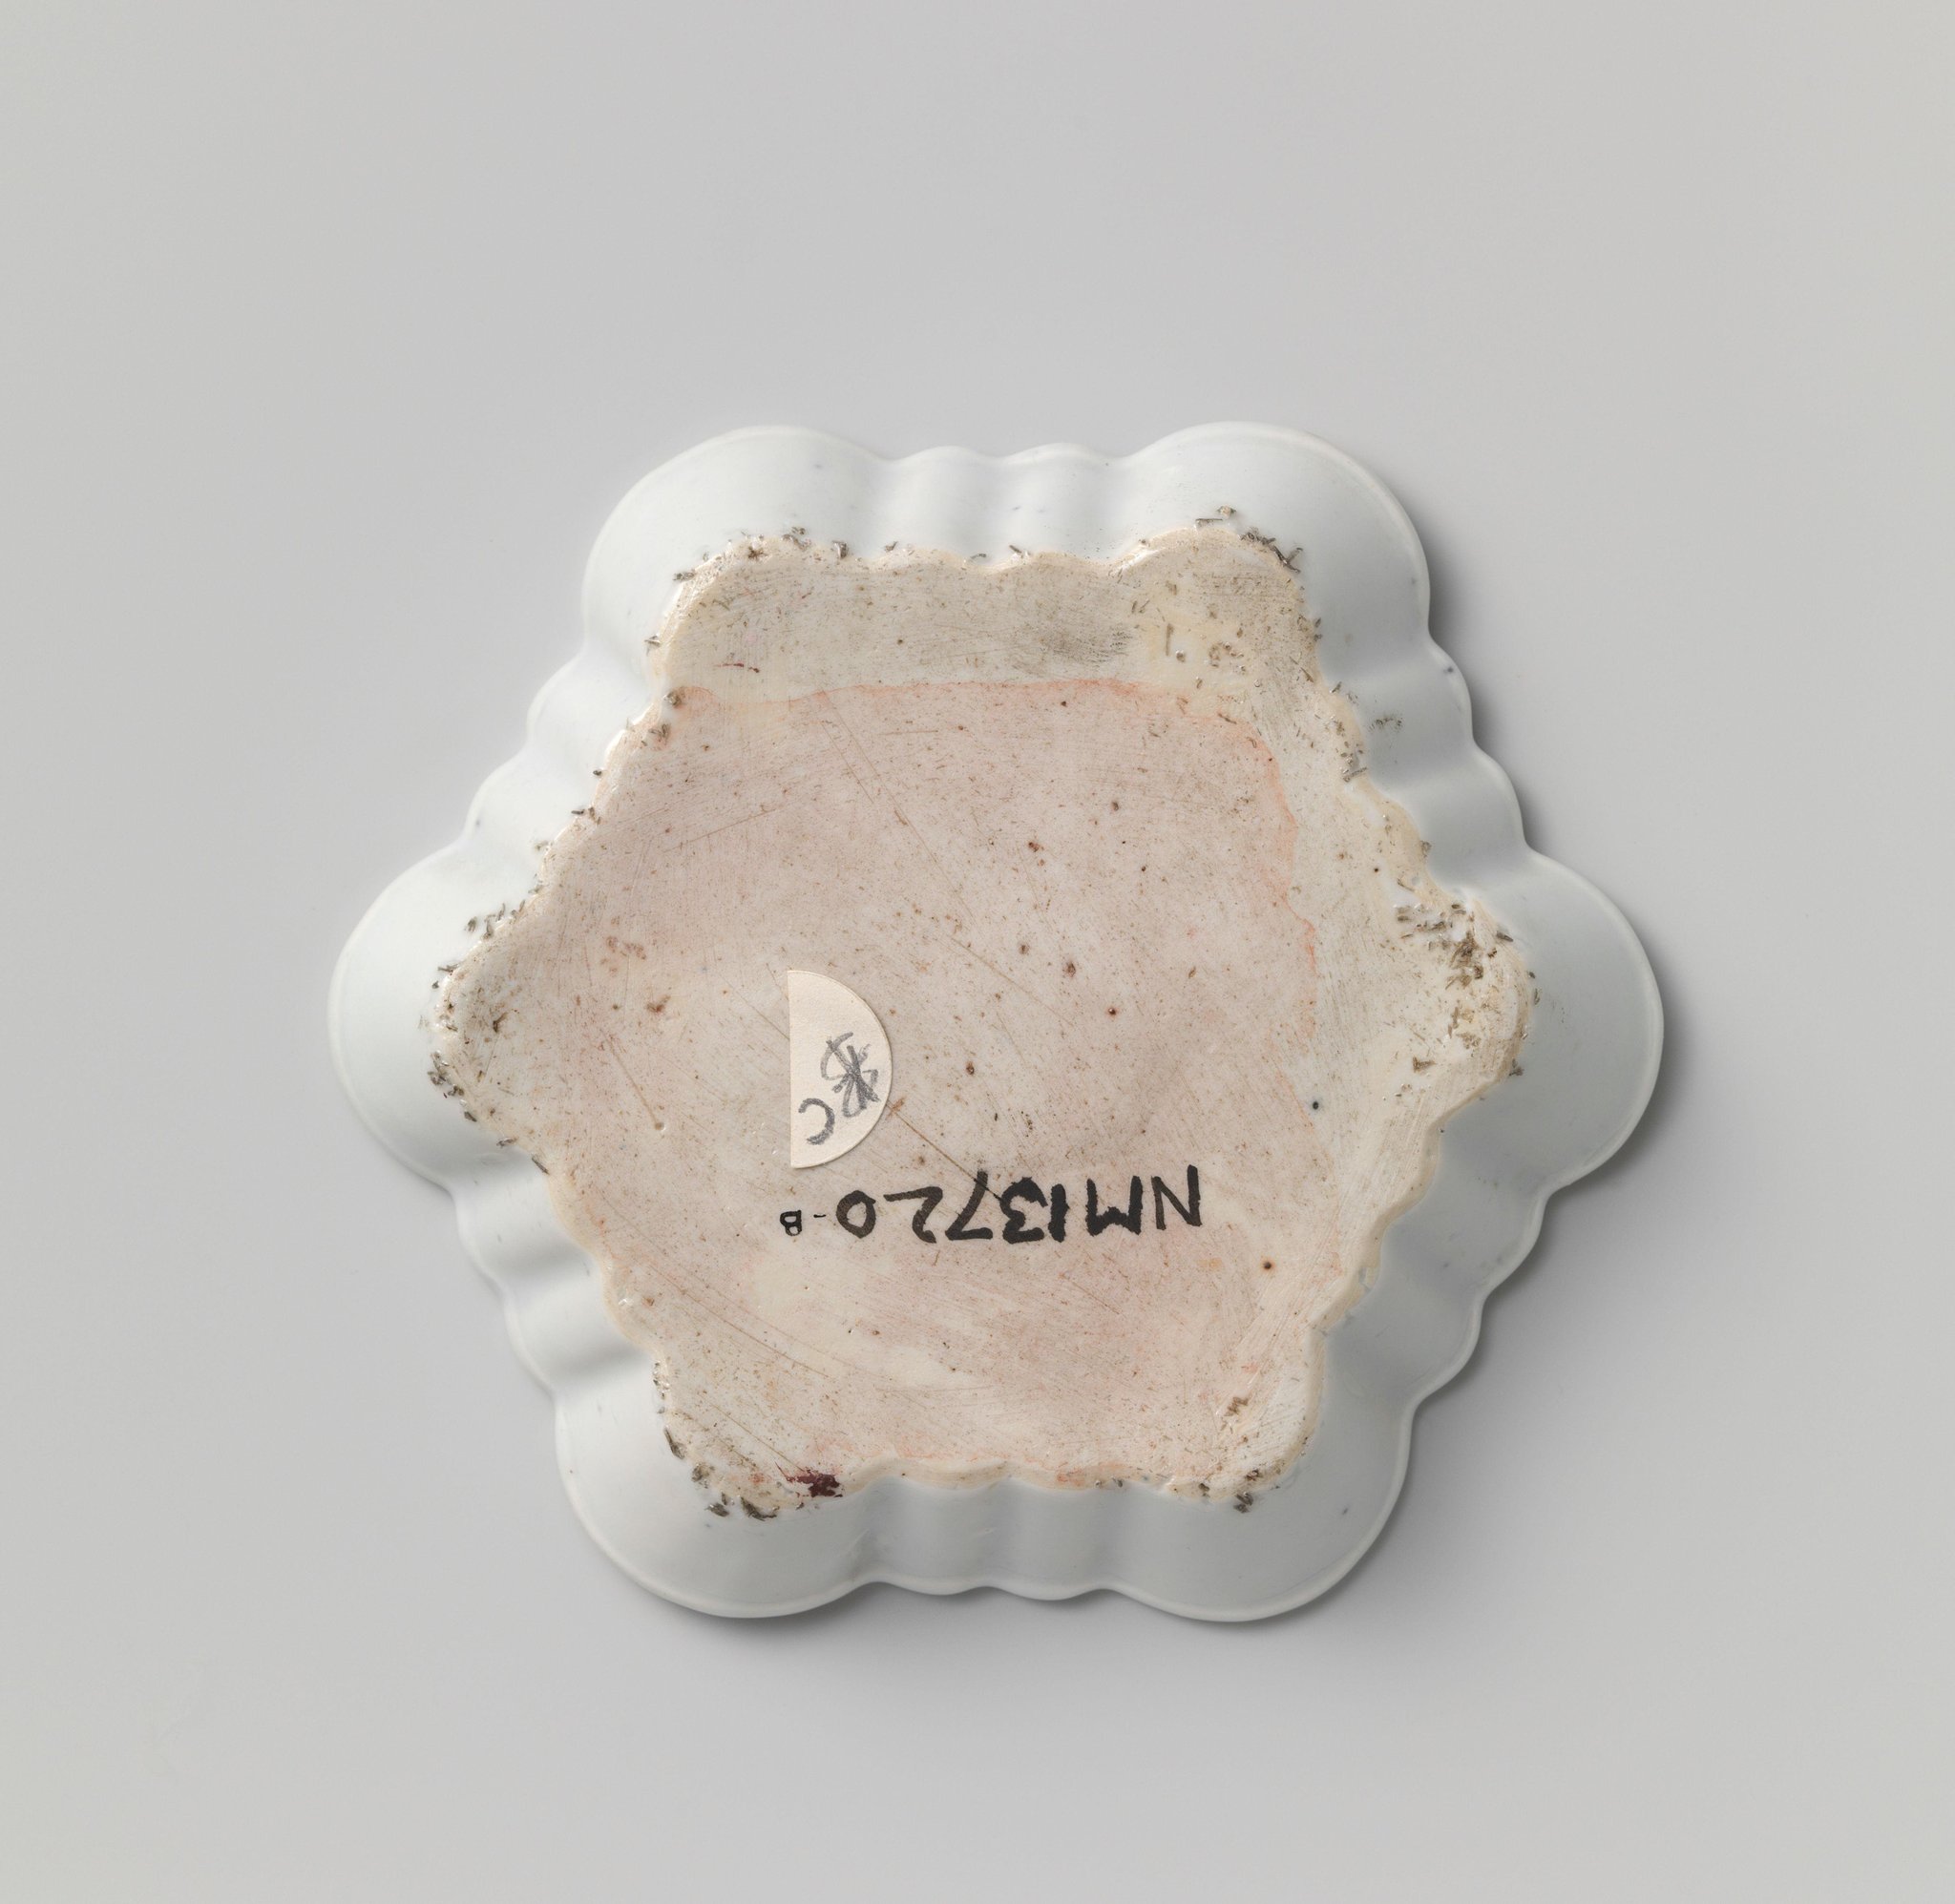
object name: pattipan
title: Teapot stand with floral scrolls, diaper pattern and flower sprays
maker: Anonymous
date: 1725-1749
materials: glaze, gold, paint, porcelain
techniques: firing, forming, gilding, vitrification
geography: china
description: Zeshoekige pattipan van porselein met gelobde wand, beschilderd op het glazuur in blauw, rood, roze, groen en goud. Op het plat grote bloemranken met hierin uitgespaard een bloemvormig medaillon met bloemtakken (pioen, aster, ballonklokje); op de wand een band servetwerk afgewisseld met bloemtakken in een cartouche. Onderzijde ongeglazuurd. Europese vormen met famille rose.